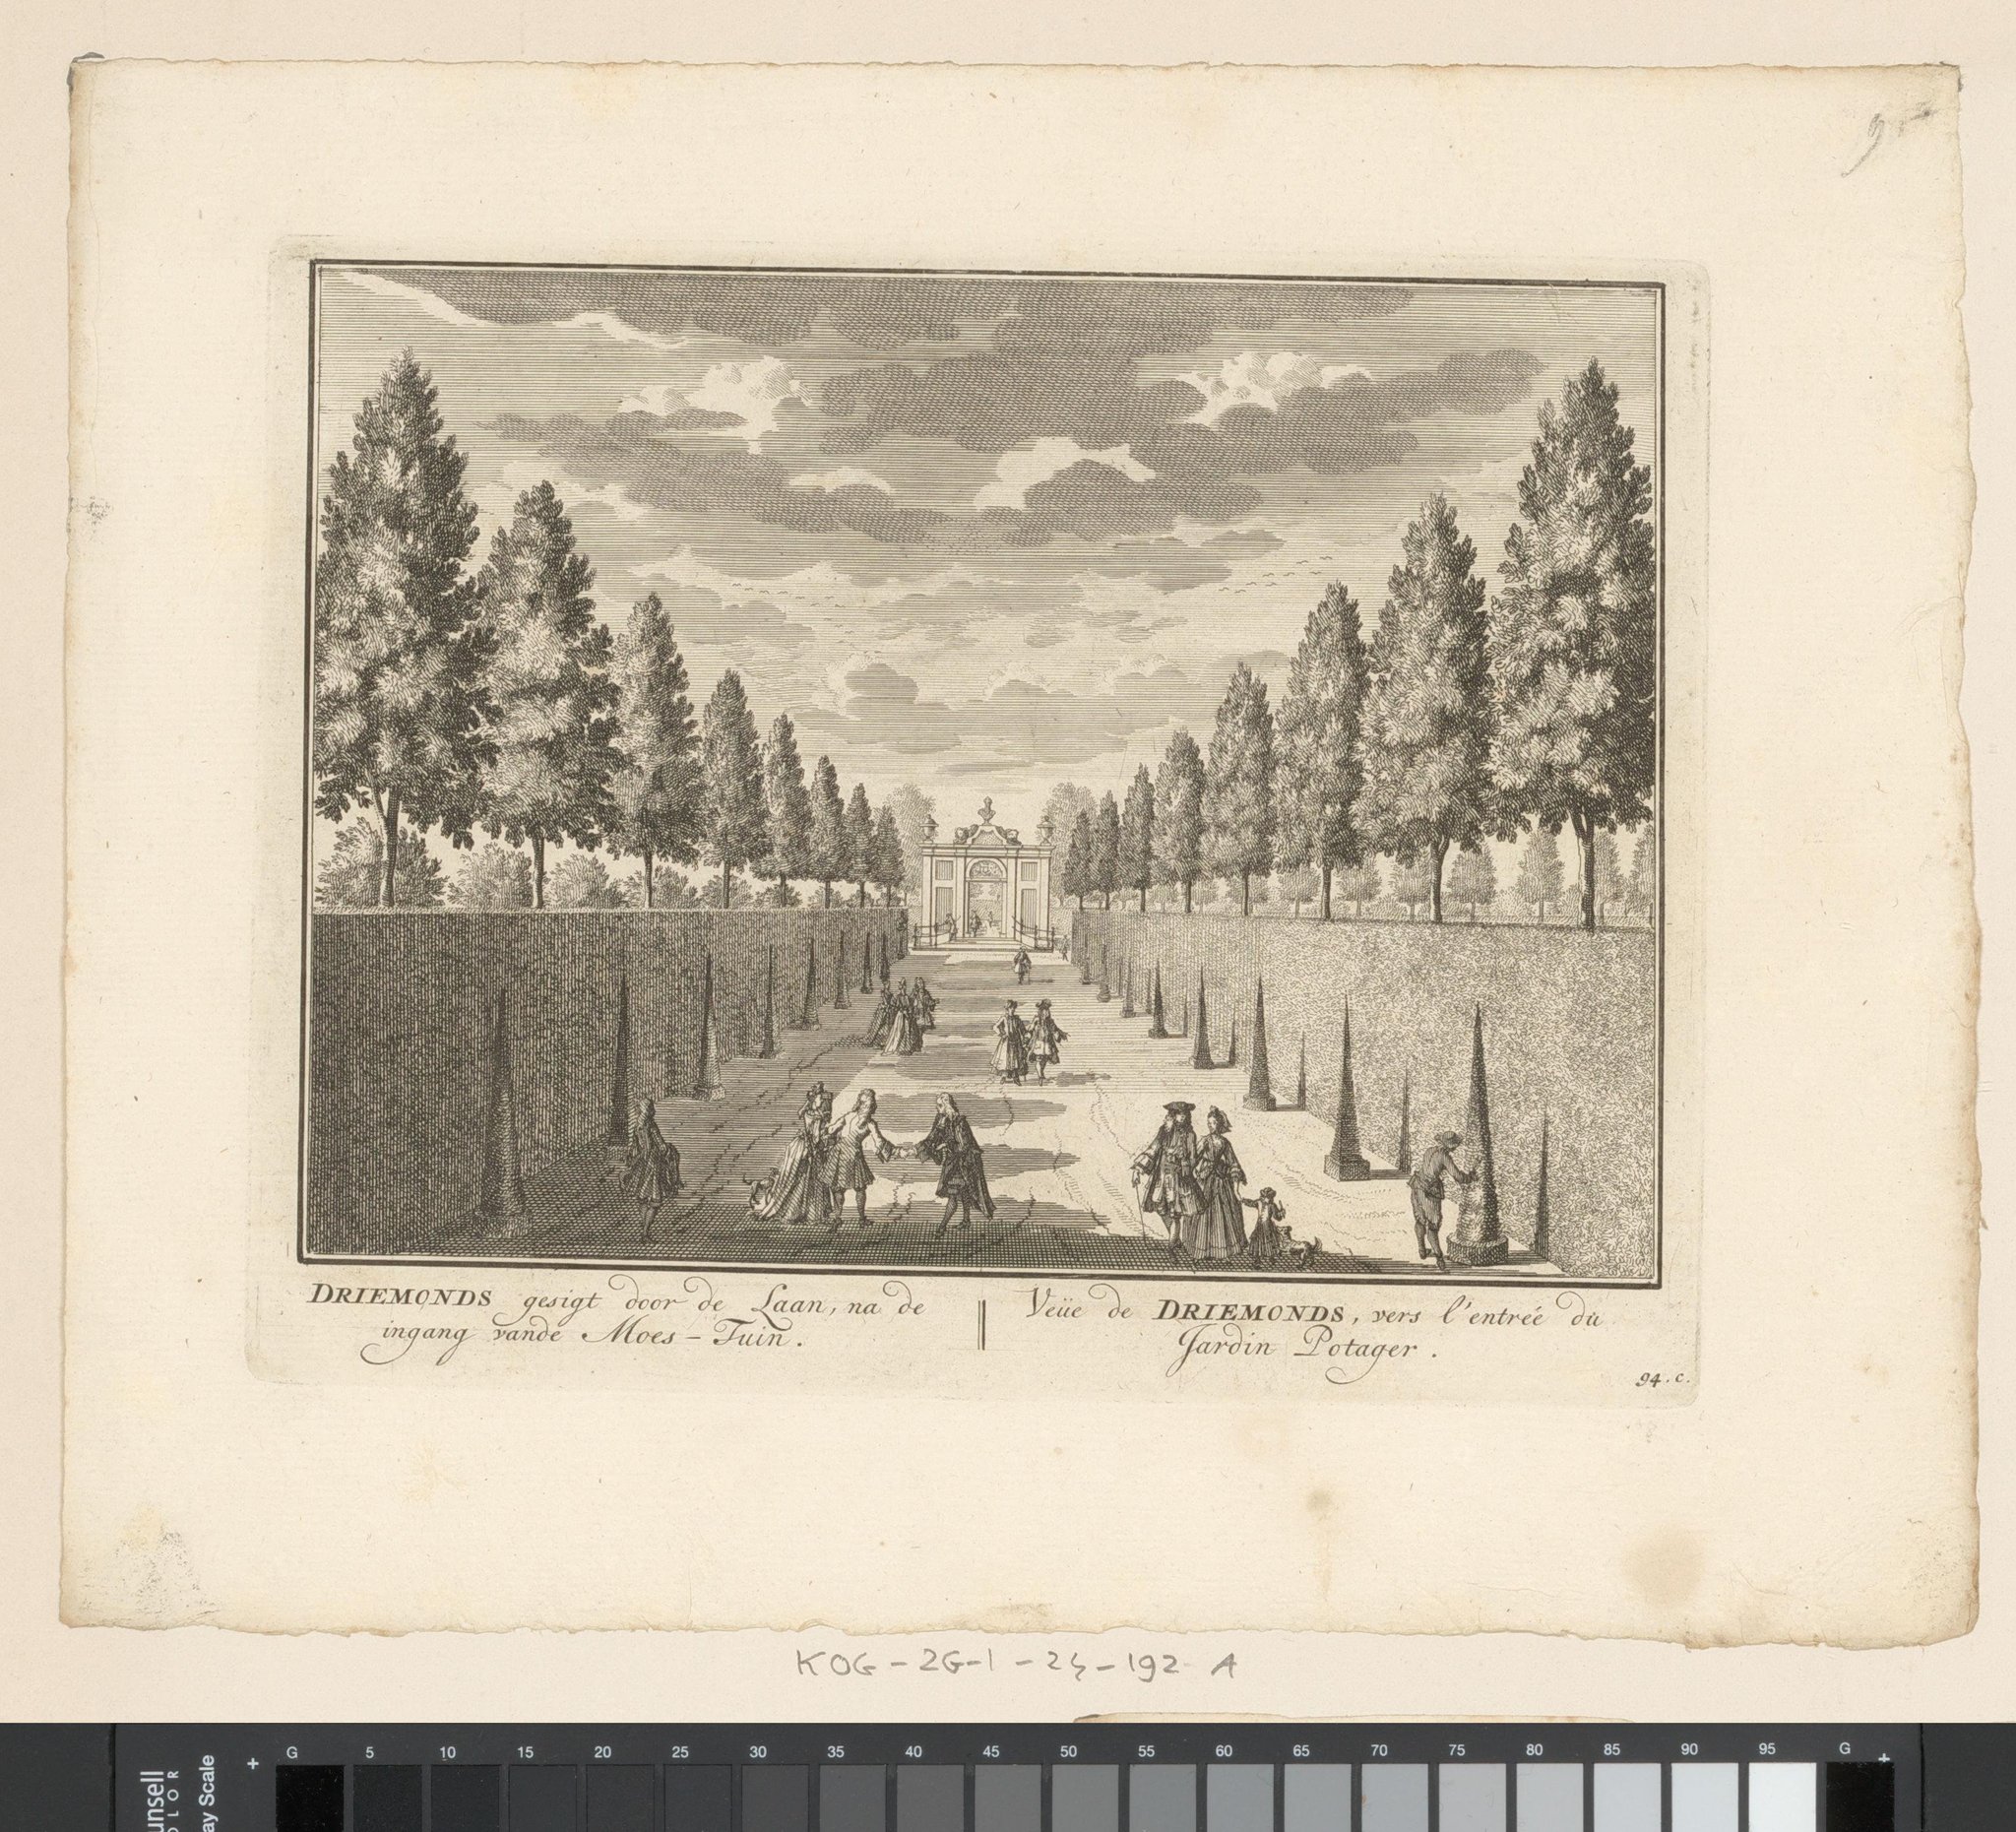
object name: print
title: Gezicht op de laan na de moestuin van buitenplaats Driemond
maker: hendrik de leth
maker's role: draughtsman, print maker, publisher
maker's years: 1703-1766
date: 1729-1732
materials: paper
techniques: engraving, etching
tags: french or architectonic garden; formal garden, forest path or lane, country-house, amsterdam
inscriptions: collector's mark: Lugt 1641, stamp, stamp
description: Prent mogelijk uit: Brouërius van Nidek, Matthaeus. Het zegepralend Kennemerland, vertoond in 100 heerlyke gezichten. Amsterdam: Jan Roman, s.a. Of uit: Brouërius van Nidek, Matthaeus. Het zegepralend Kennemerland, vertoond in veele heerlyke gezichten. Amsterdam: Andries en Hendrik de Leth, s.a [1729-1732]. Of uit: Brouërius van Nidek, Matthaeus. Het zegepralend Kennemerland, vertoond in veele heerlyke gezichten. Amsterdam: Jan Roman, s.a.